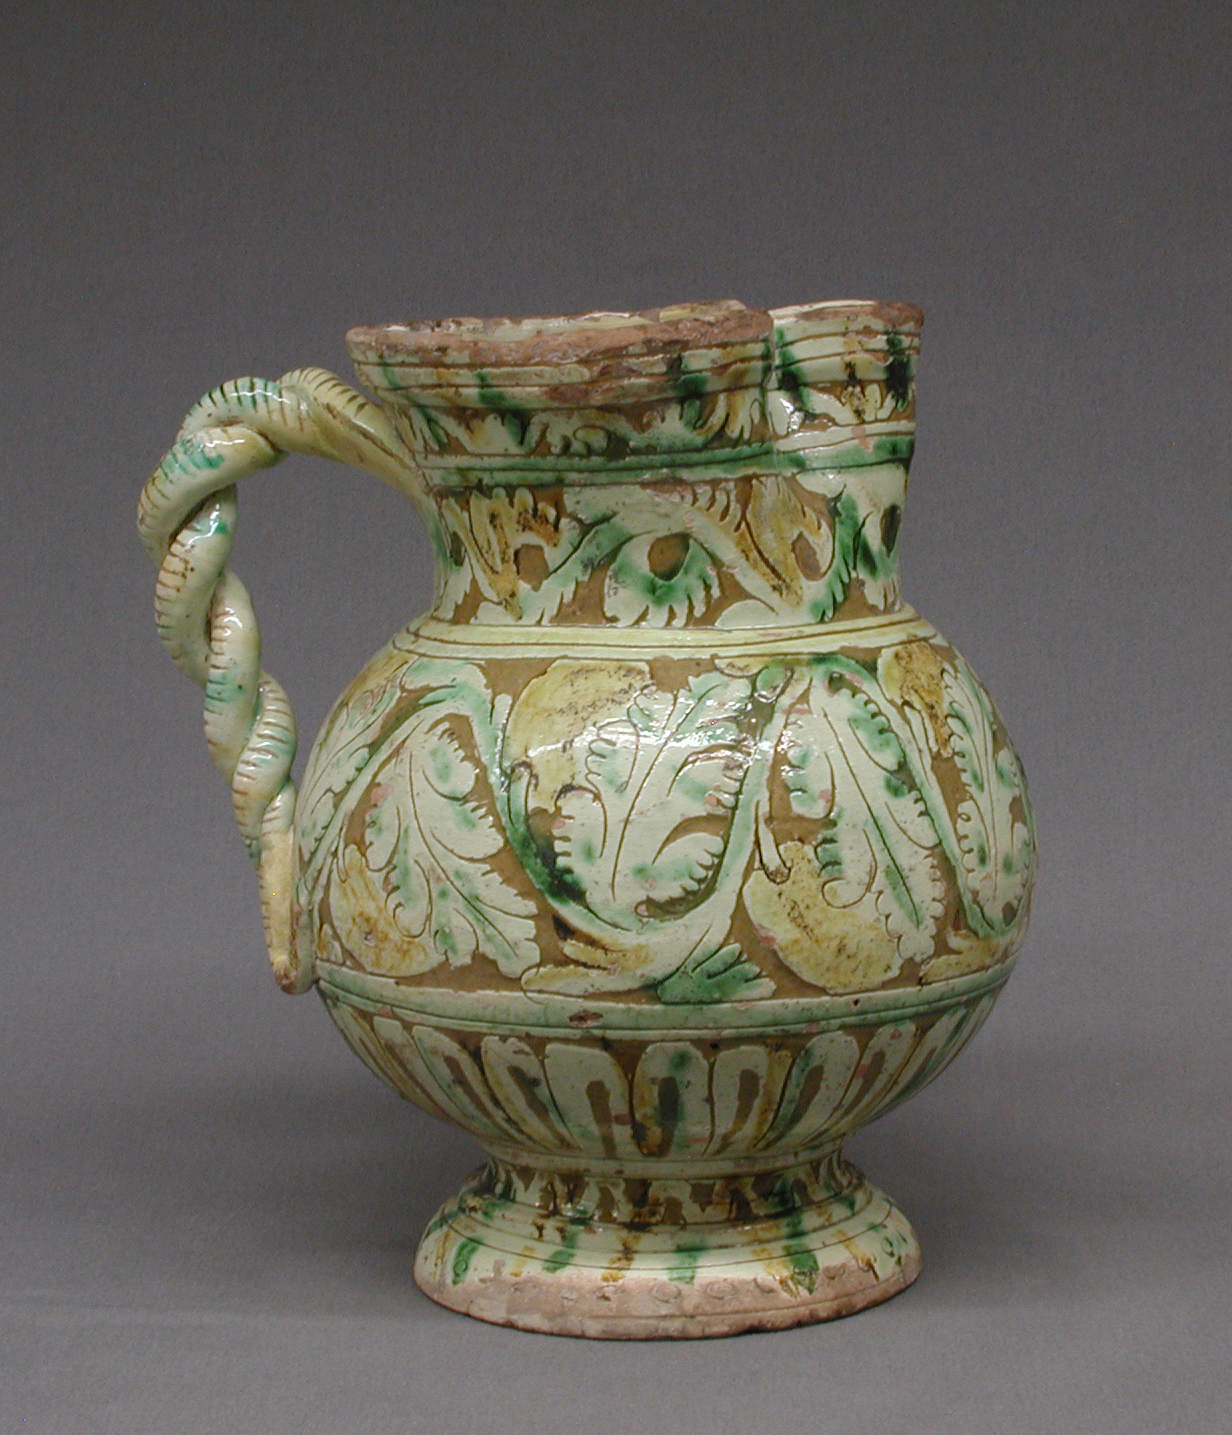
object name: jug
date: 1551-1600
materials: earthenware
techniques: glazing